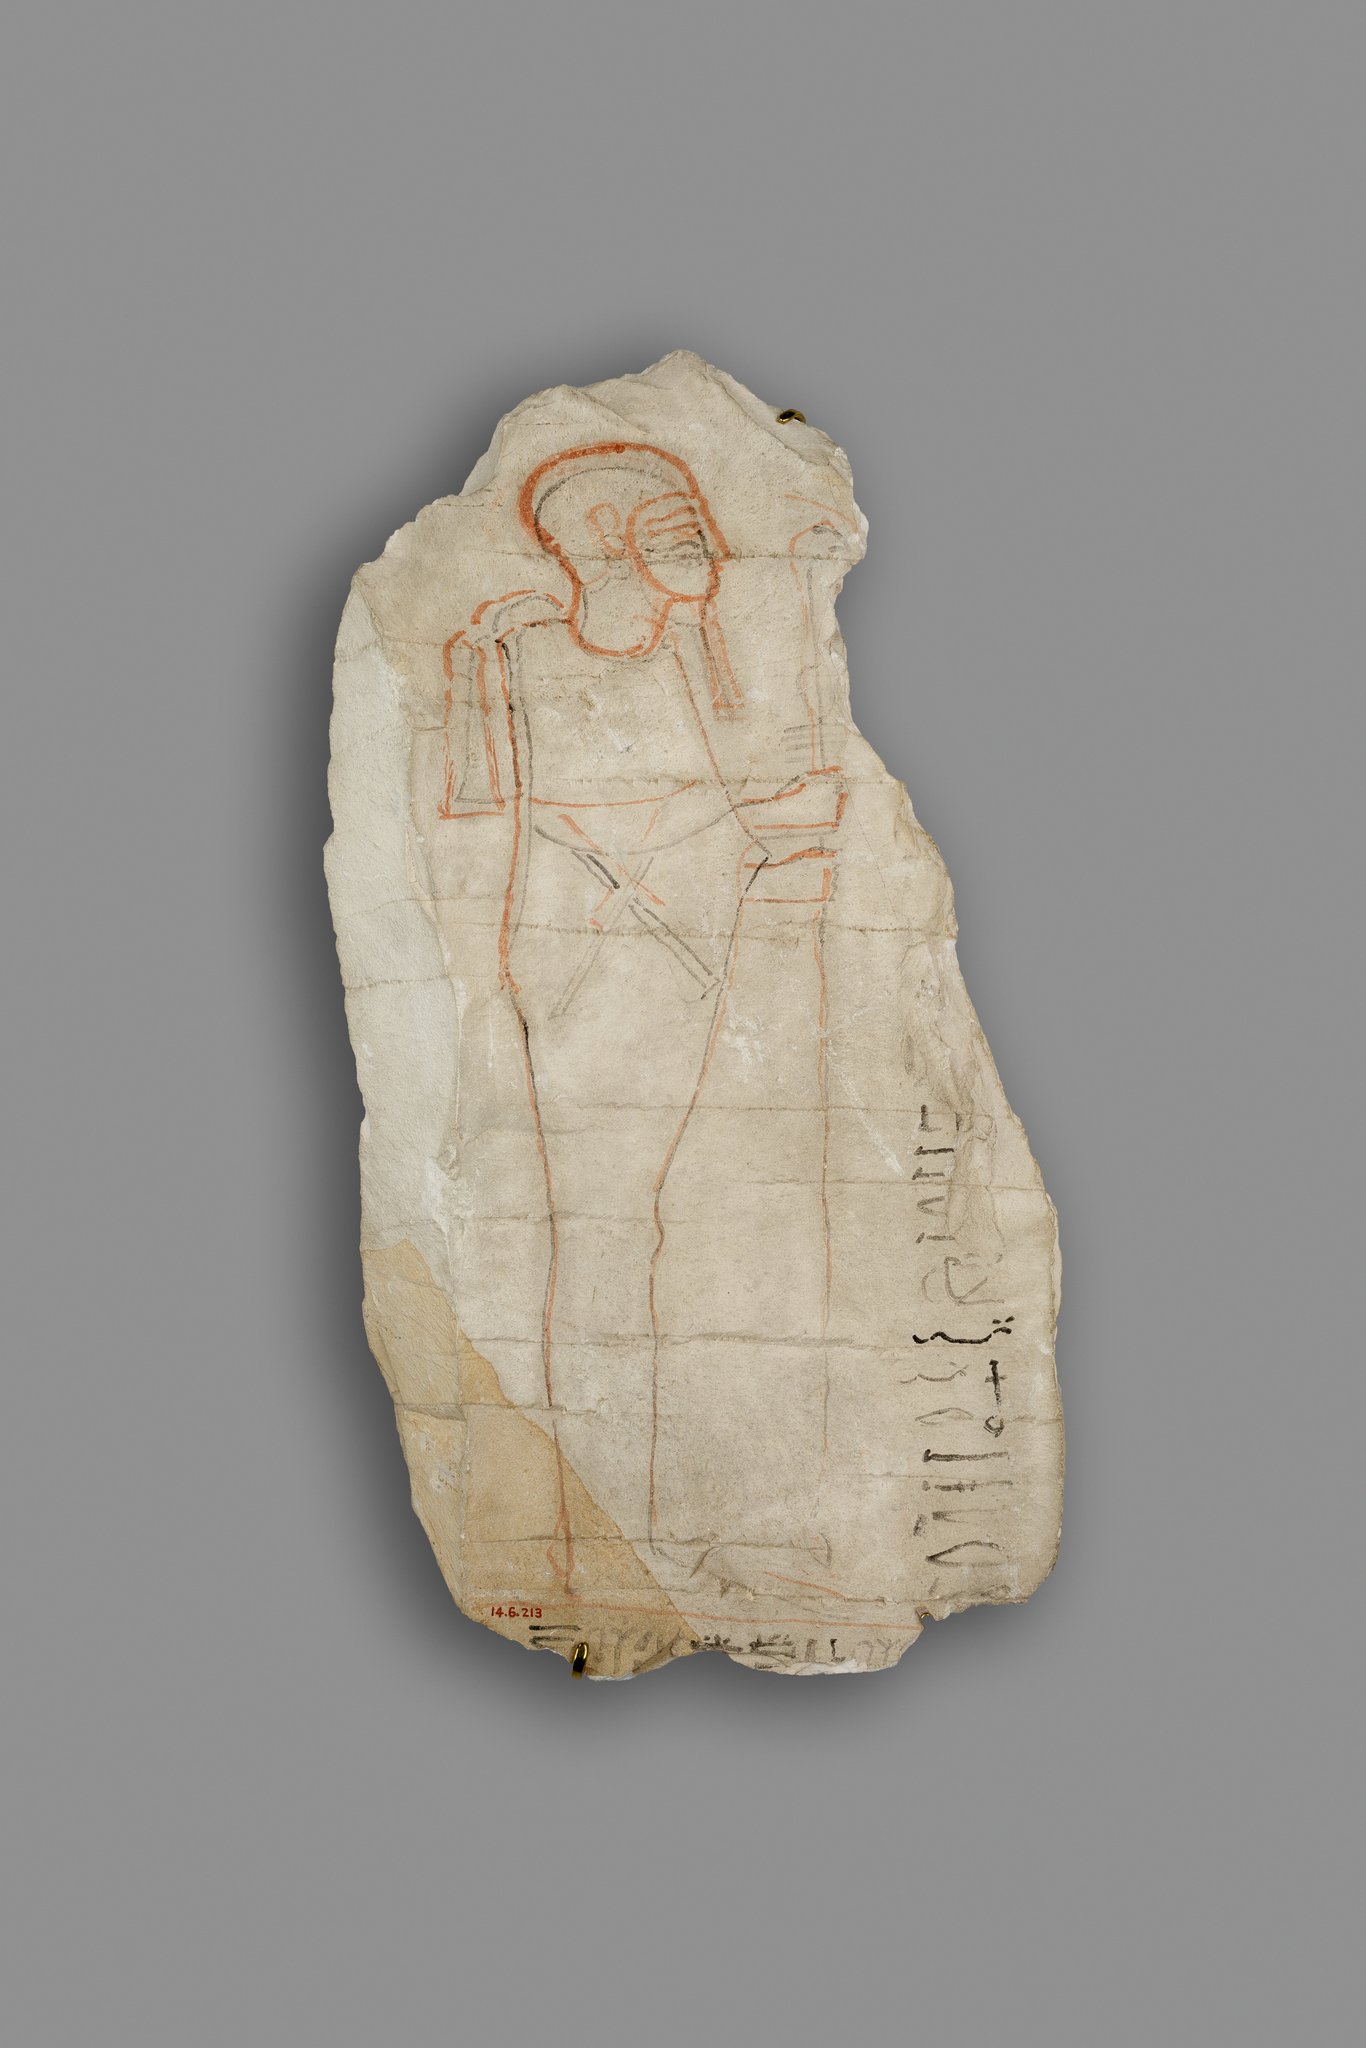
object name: ostracon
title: Ostracon with Figure of the God Ptah and Artist's Signature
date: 1295-1070 BCE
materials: ink, limestone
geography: egypt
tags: human figures